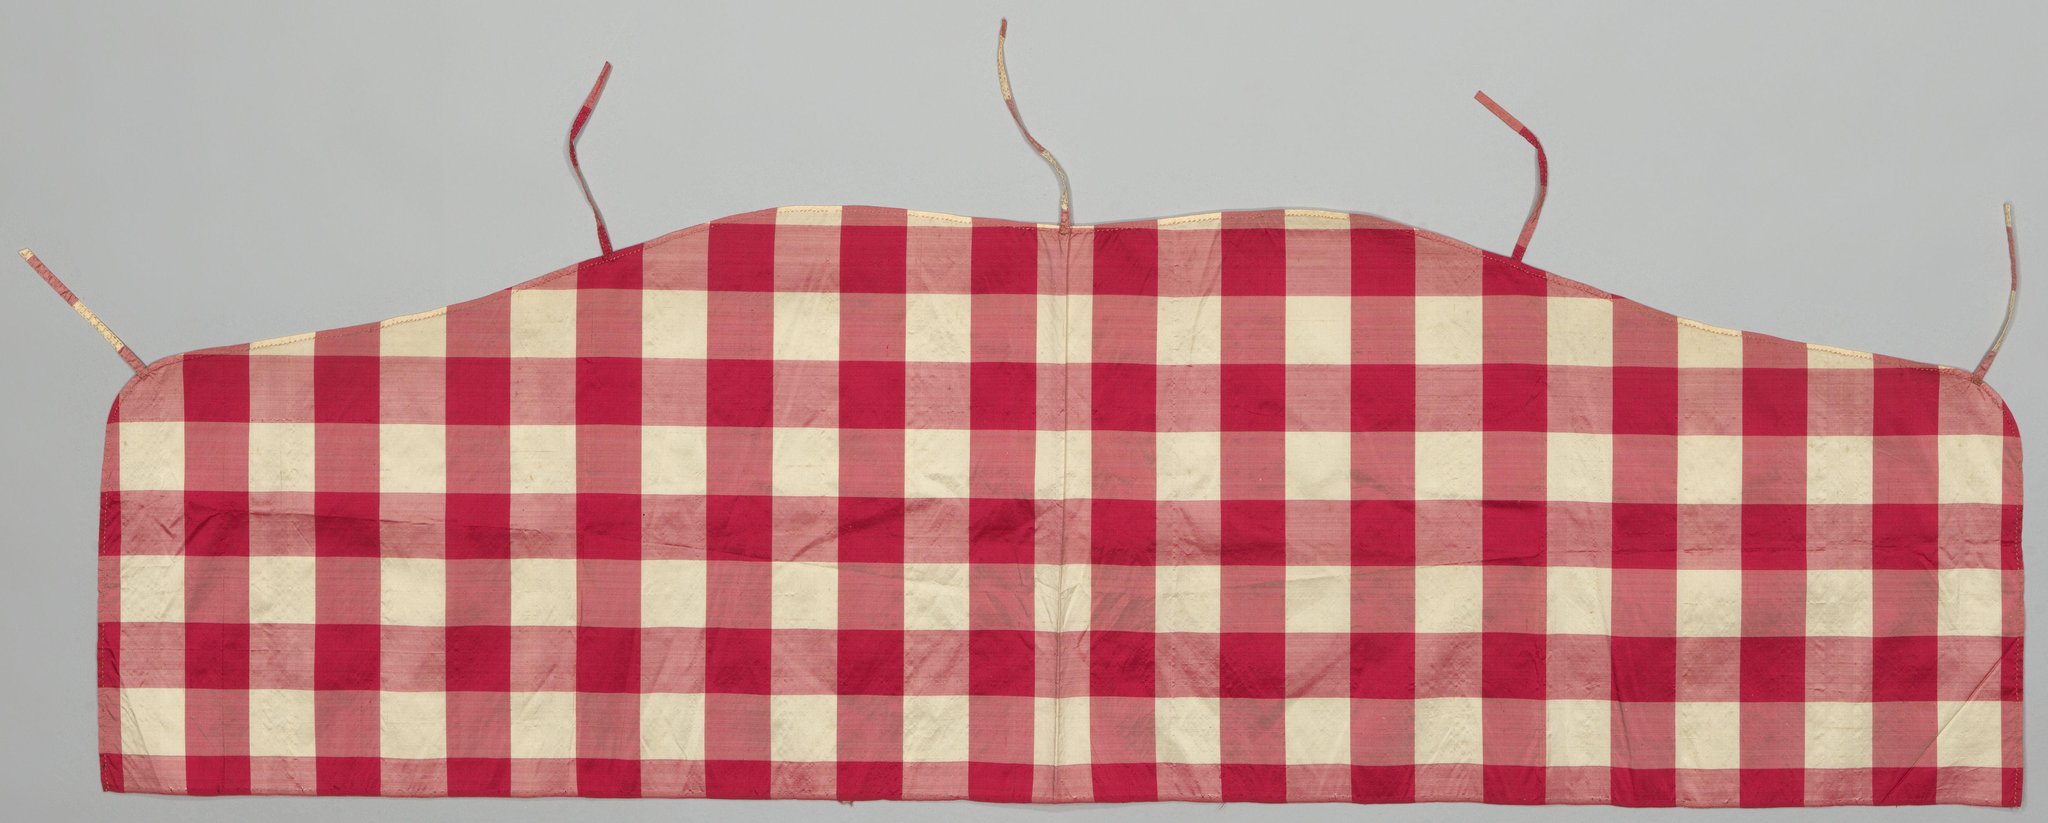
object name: silk textile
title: Gordijngarnituur, mogelijk een gordijnval, van rood-wit geblokte zijde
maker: Anonymous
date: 1776-1800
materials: silk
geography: northern netherlands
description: Geschulpte gordijngarnituur, mogelijk een gordijnval, van rood-wit geblokte zijde, licht golvend, met vijf bandjes van dezelfde stof van ca. 10.0 cm.